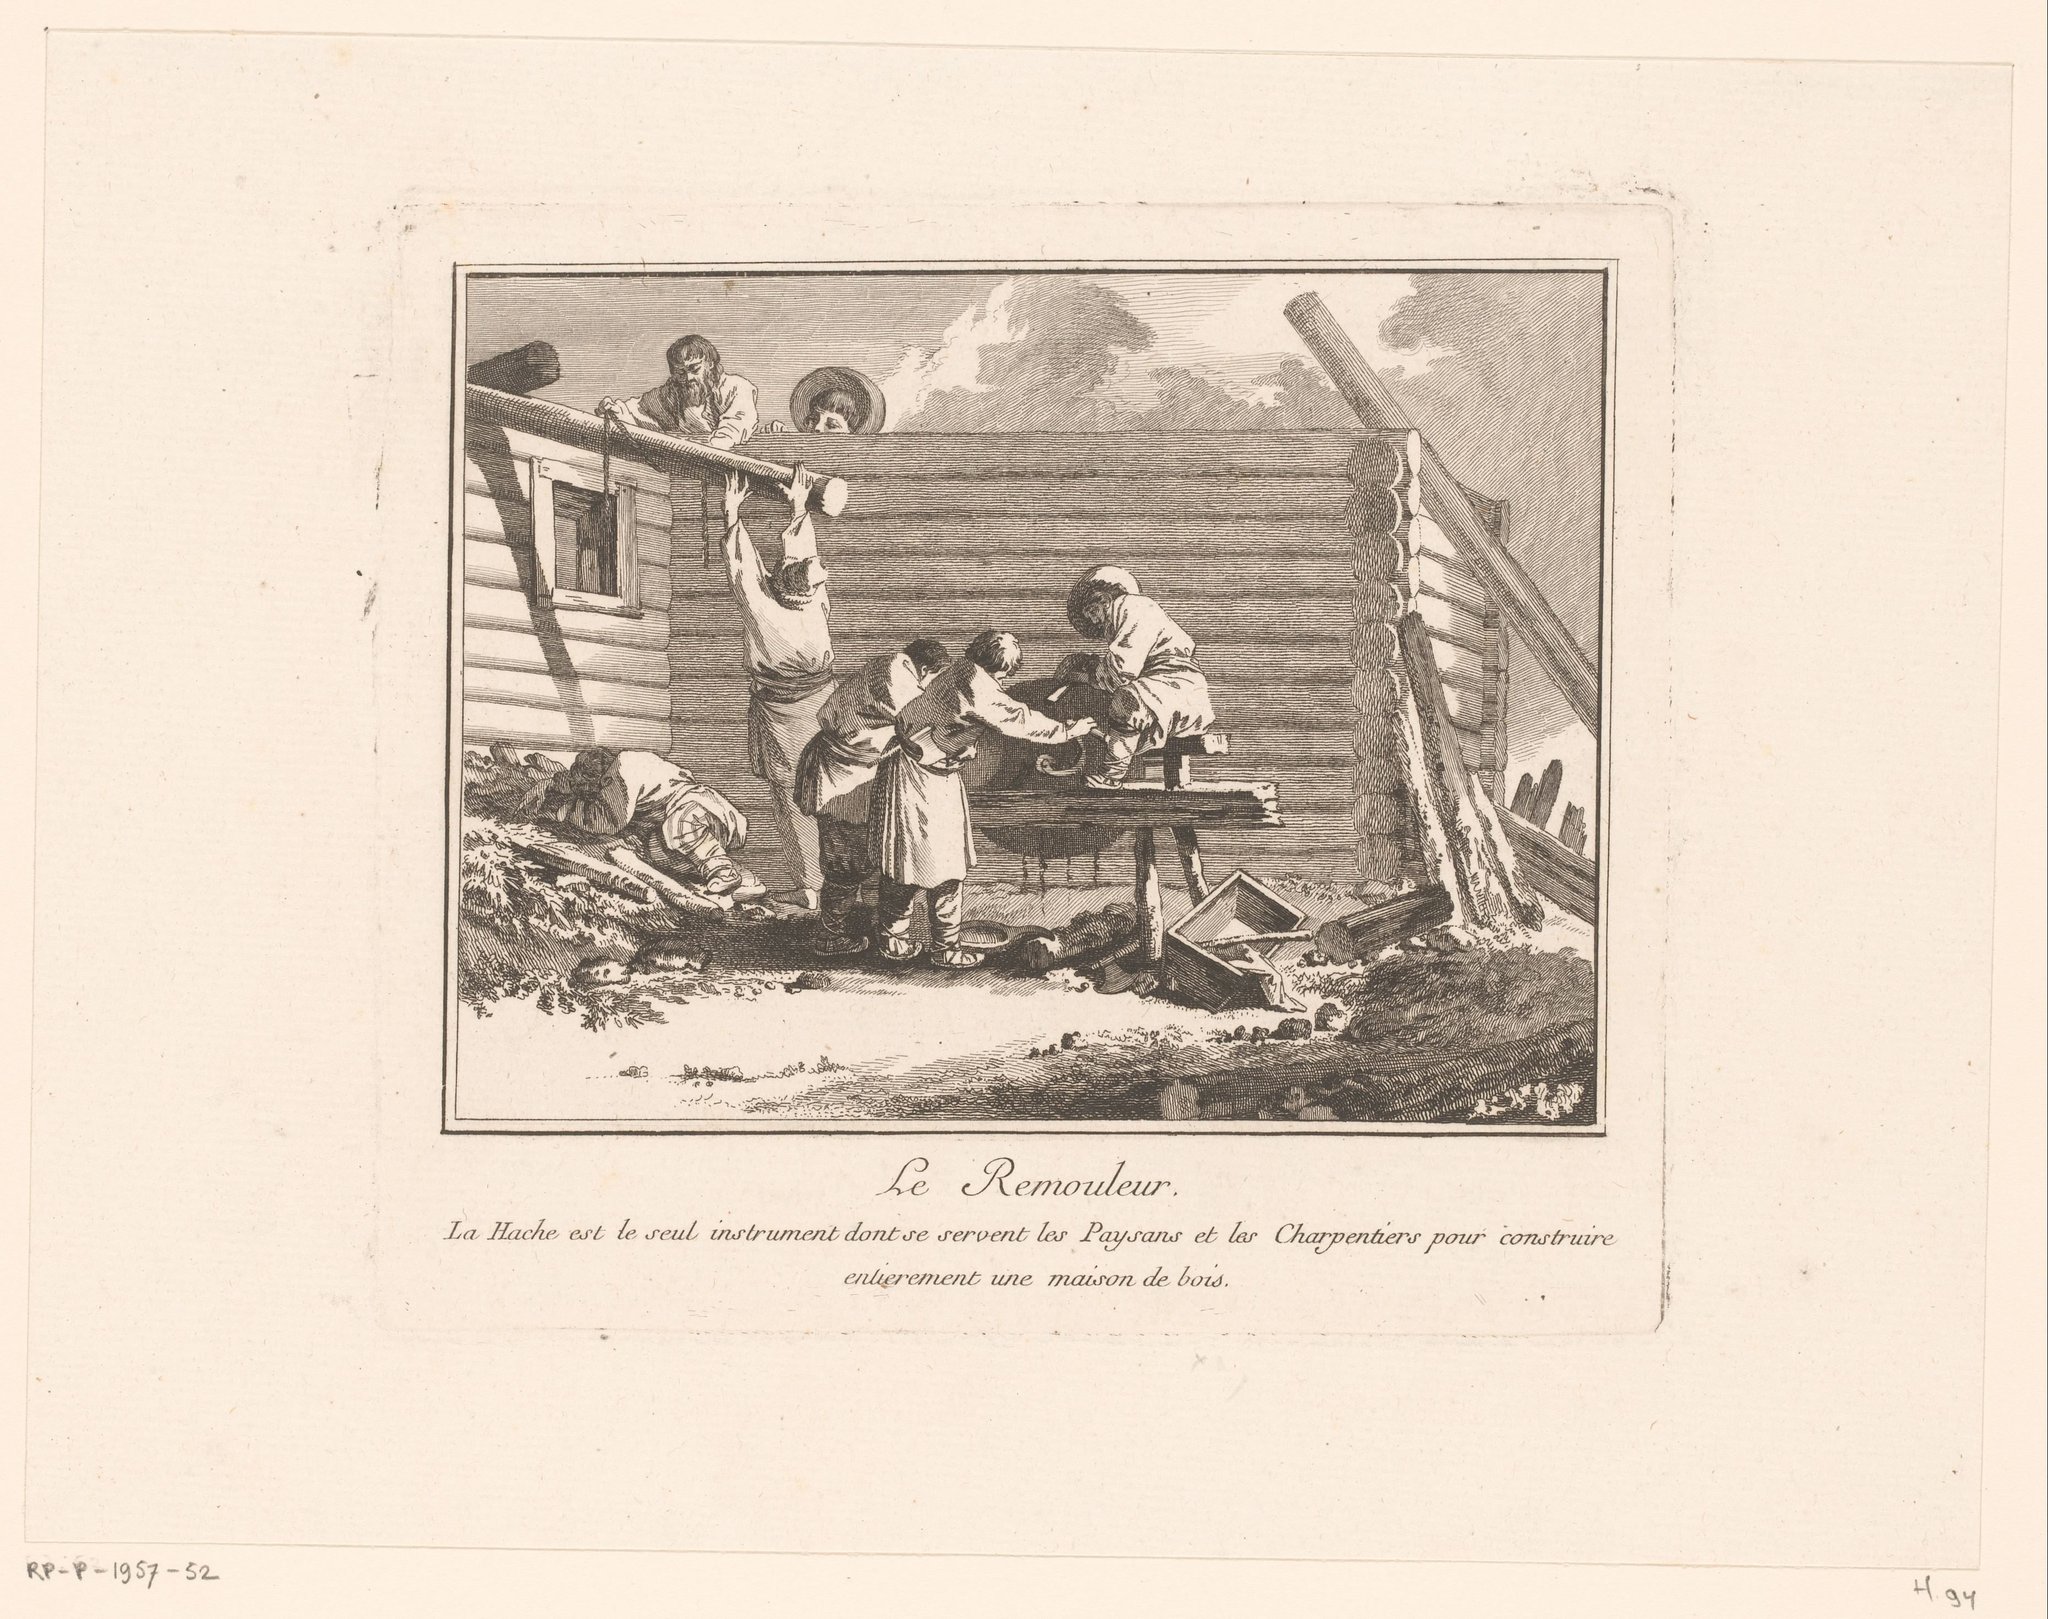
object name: print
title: Le Remouleur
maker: jean baptist leprince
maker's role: draughtsman, print maker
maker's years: 1734-1781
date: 1744-1781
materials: paper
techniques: etching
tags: building activities, sharpening, grinding (industrial processes)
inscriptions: collector's mark: Lugt 2228, collector's mark: ‘Douane Centrale. Exportation Paris’